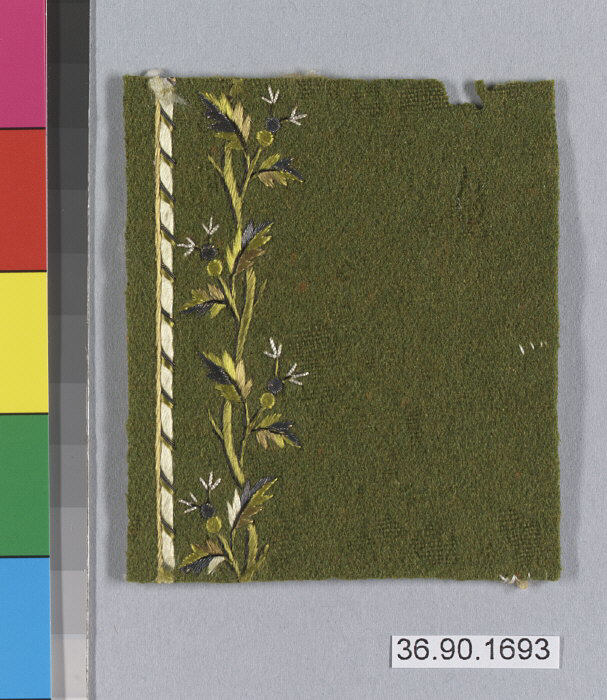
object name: sample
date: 1801-1833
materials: felt, metal thread, silk